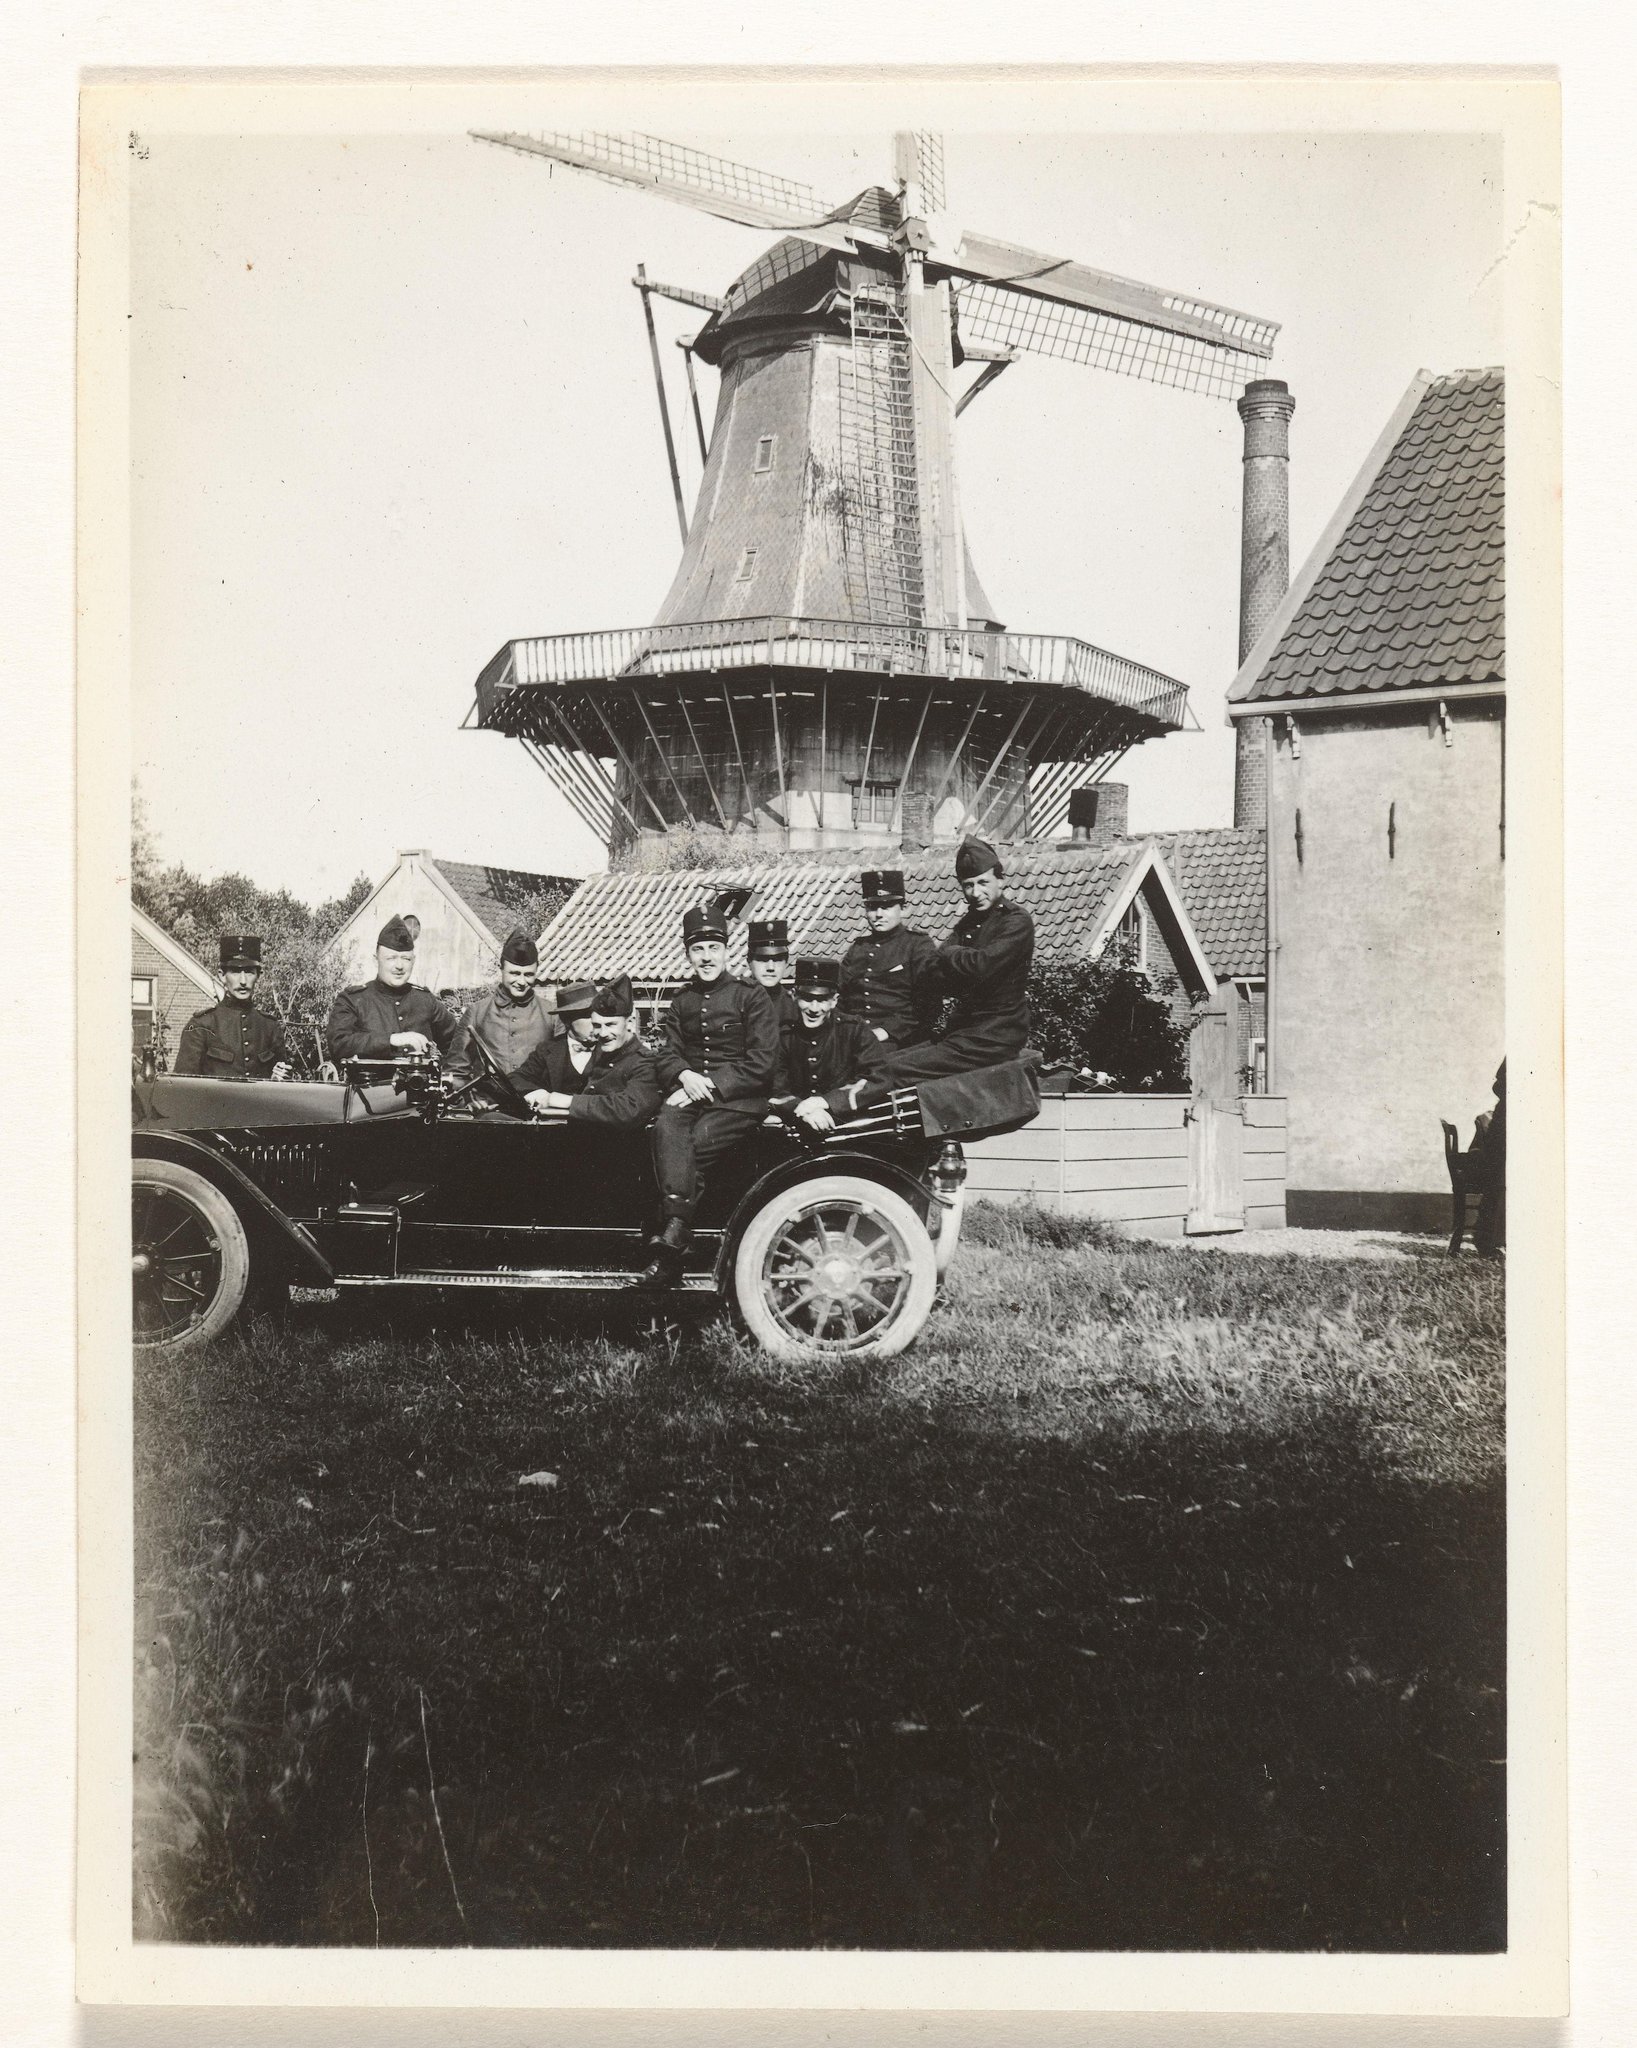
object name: photograph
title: Soldaten in een Hupmobile voor korenmolen de Eendracht in Alphen aan den Rijn, tijdens de algehele mobilisatie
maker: dirk van der mark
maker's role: amateurfotograaf, handelaar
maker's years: 1877-1934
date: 1914-1918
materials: paper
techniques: gelatin silver print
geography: alphen aan den rijn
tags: the soldier; the soldier's life, automobile, windmill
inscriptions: inscription: ‘Mobilisatie 1914/18/ Hupmobile Dirk van der Mark Jr’, number: ‘13’